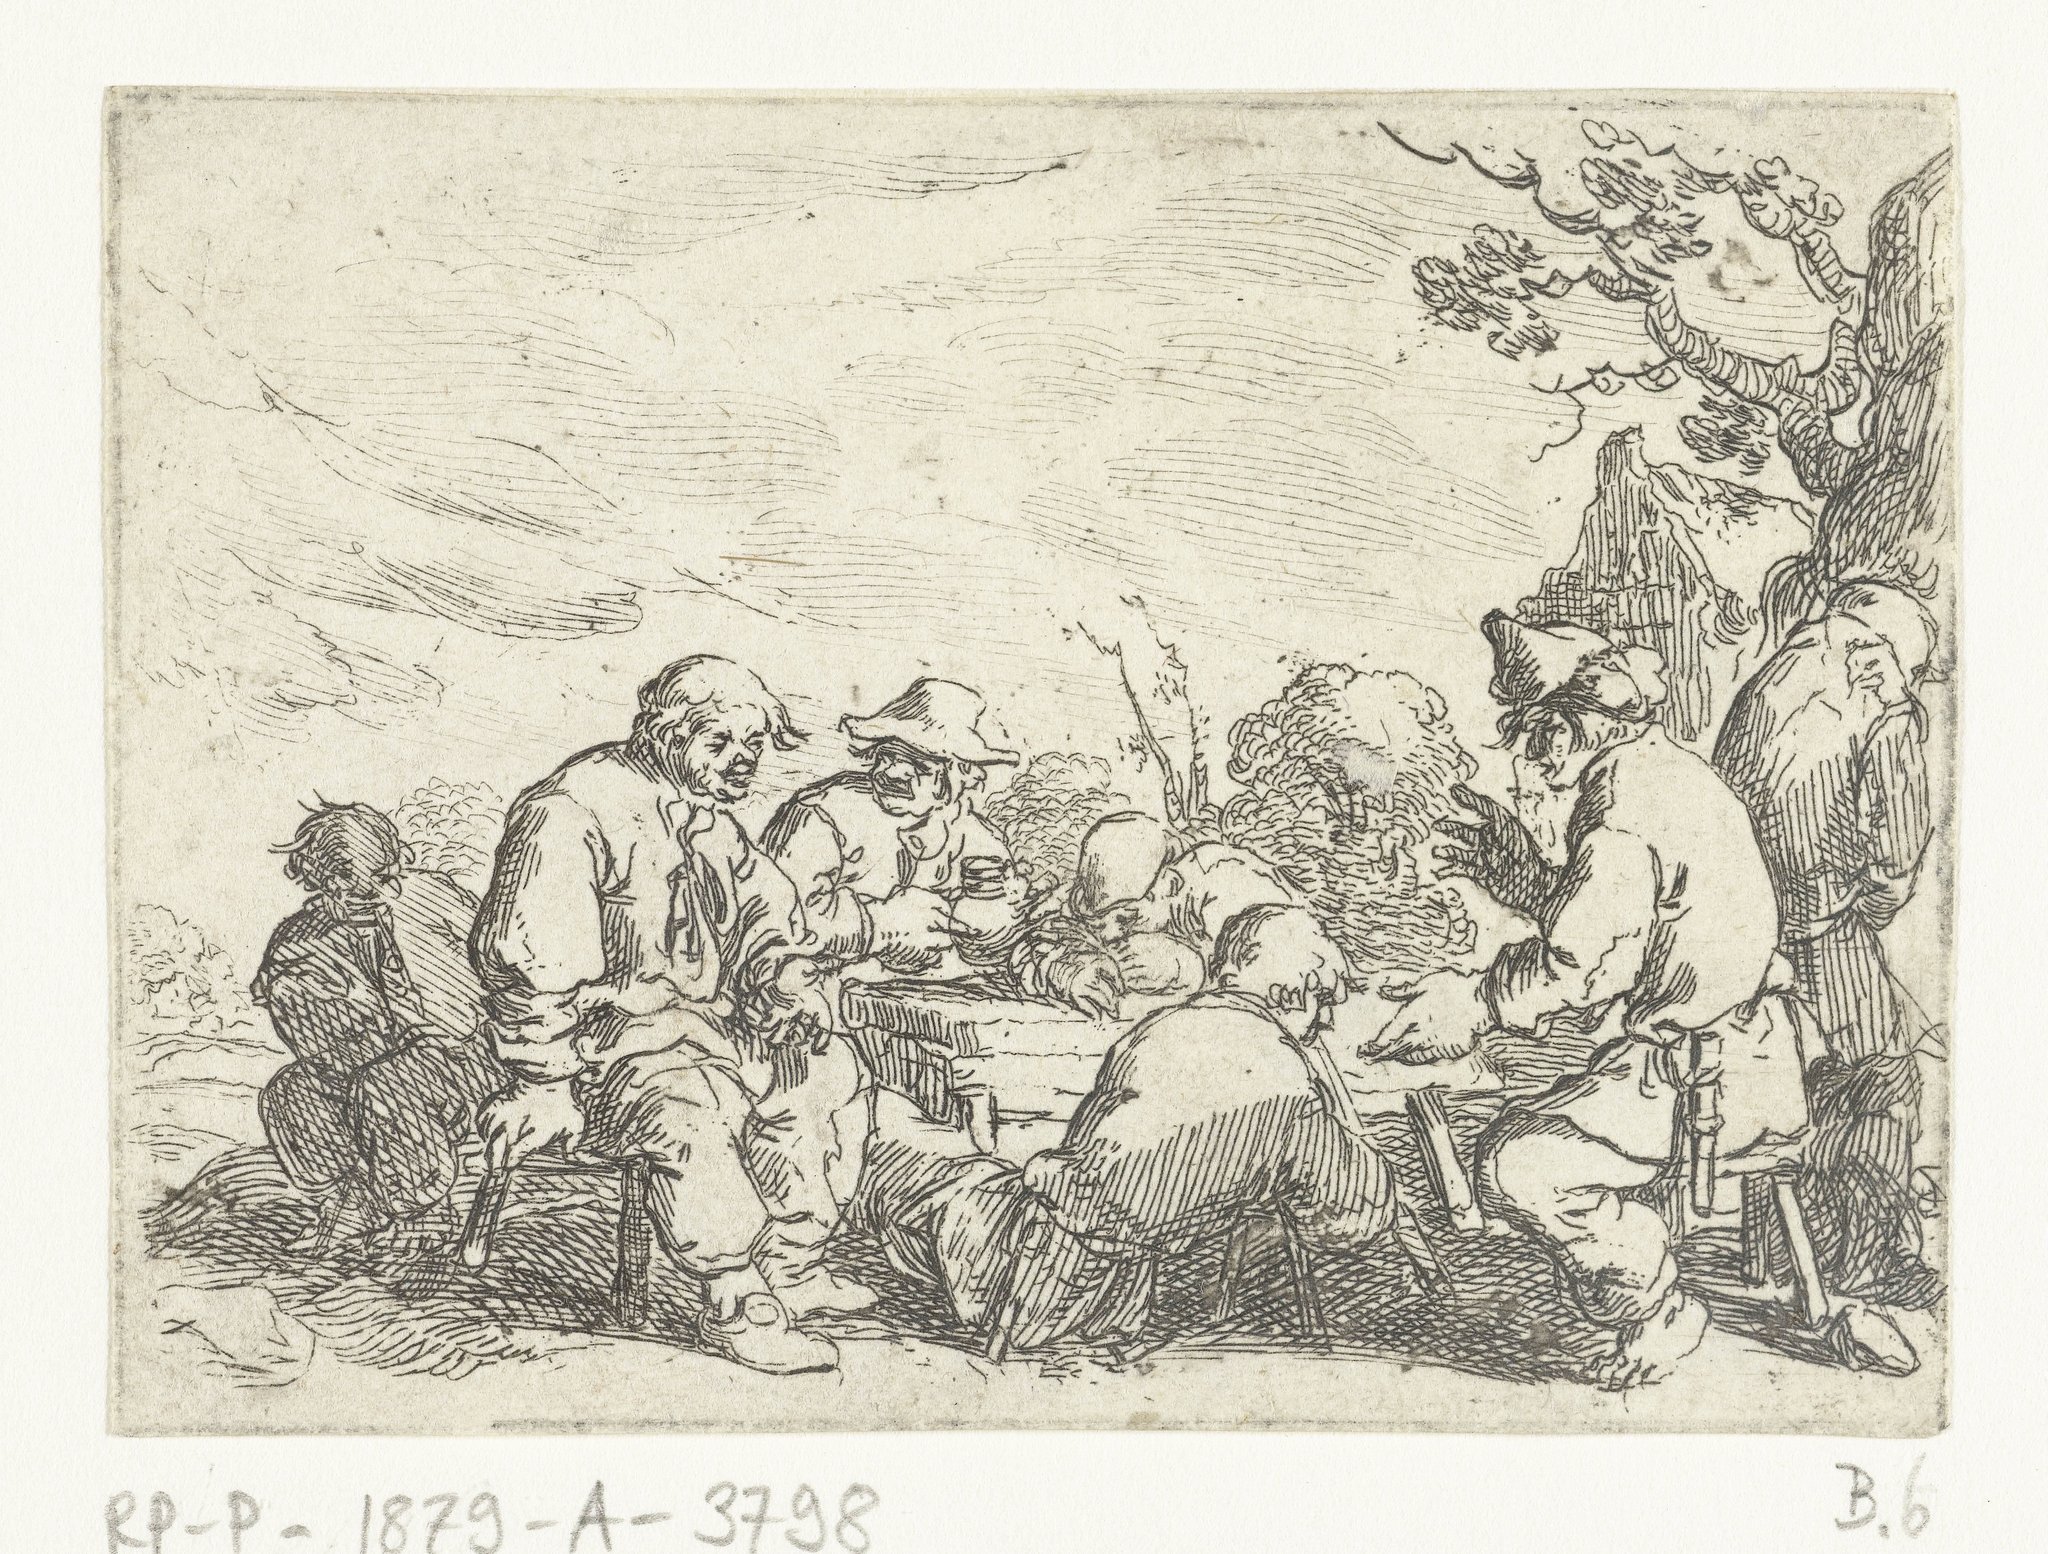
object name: print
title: Drinkende boeren aan een tafel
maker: andries both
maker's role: draughtsman, painter, print maker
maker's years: 1612-1642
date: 1622-1642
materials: paper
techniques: etching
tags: drunkenness, falling, urination (+ three-quarter view)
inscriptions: collector's mark: Lugt 2228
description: Een groep drinkende boeren zit aan tafel in de buitenlucht bij een boom. Een boer valt van zijn kruk, een ander plast tegen de boom.